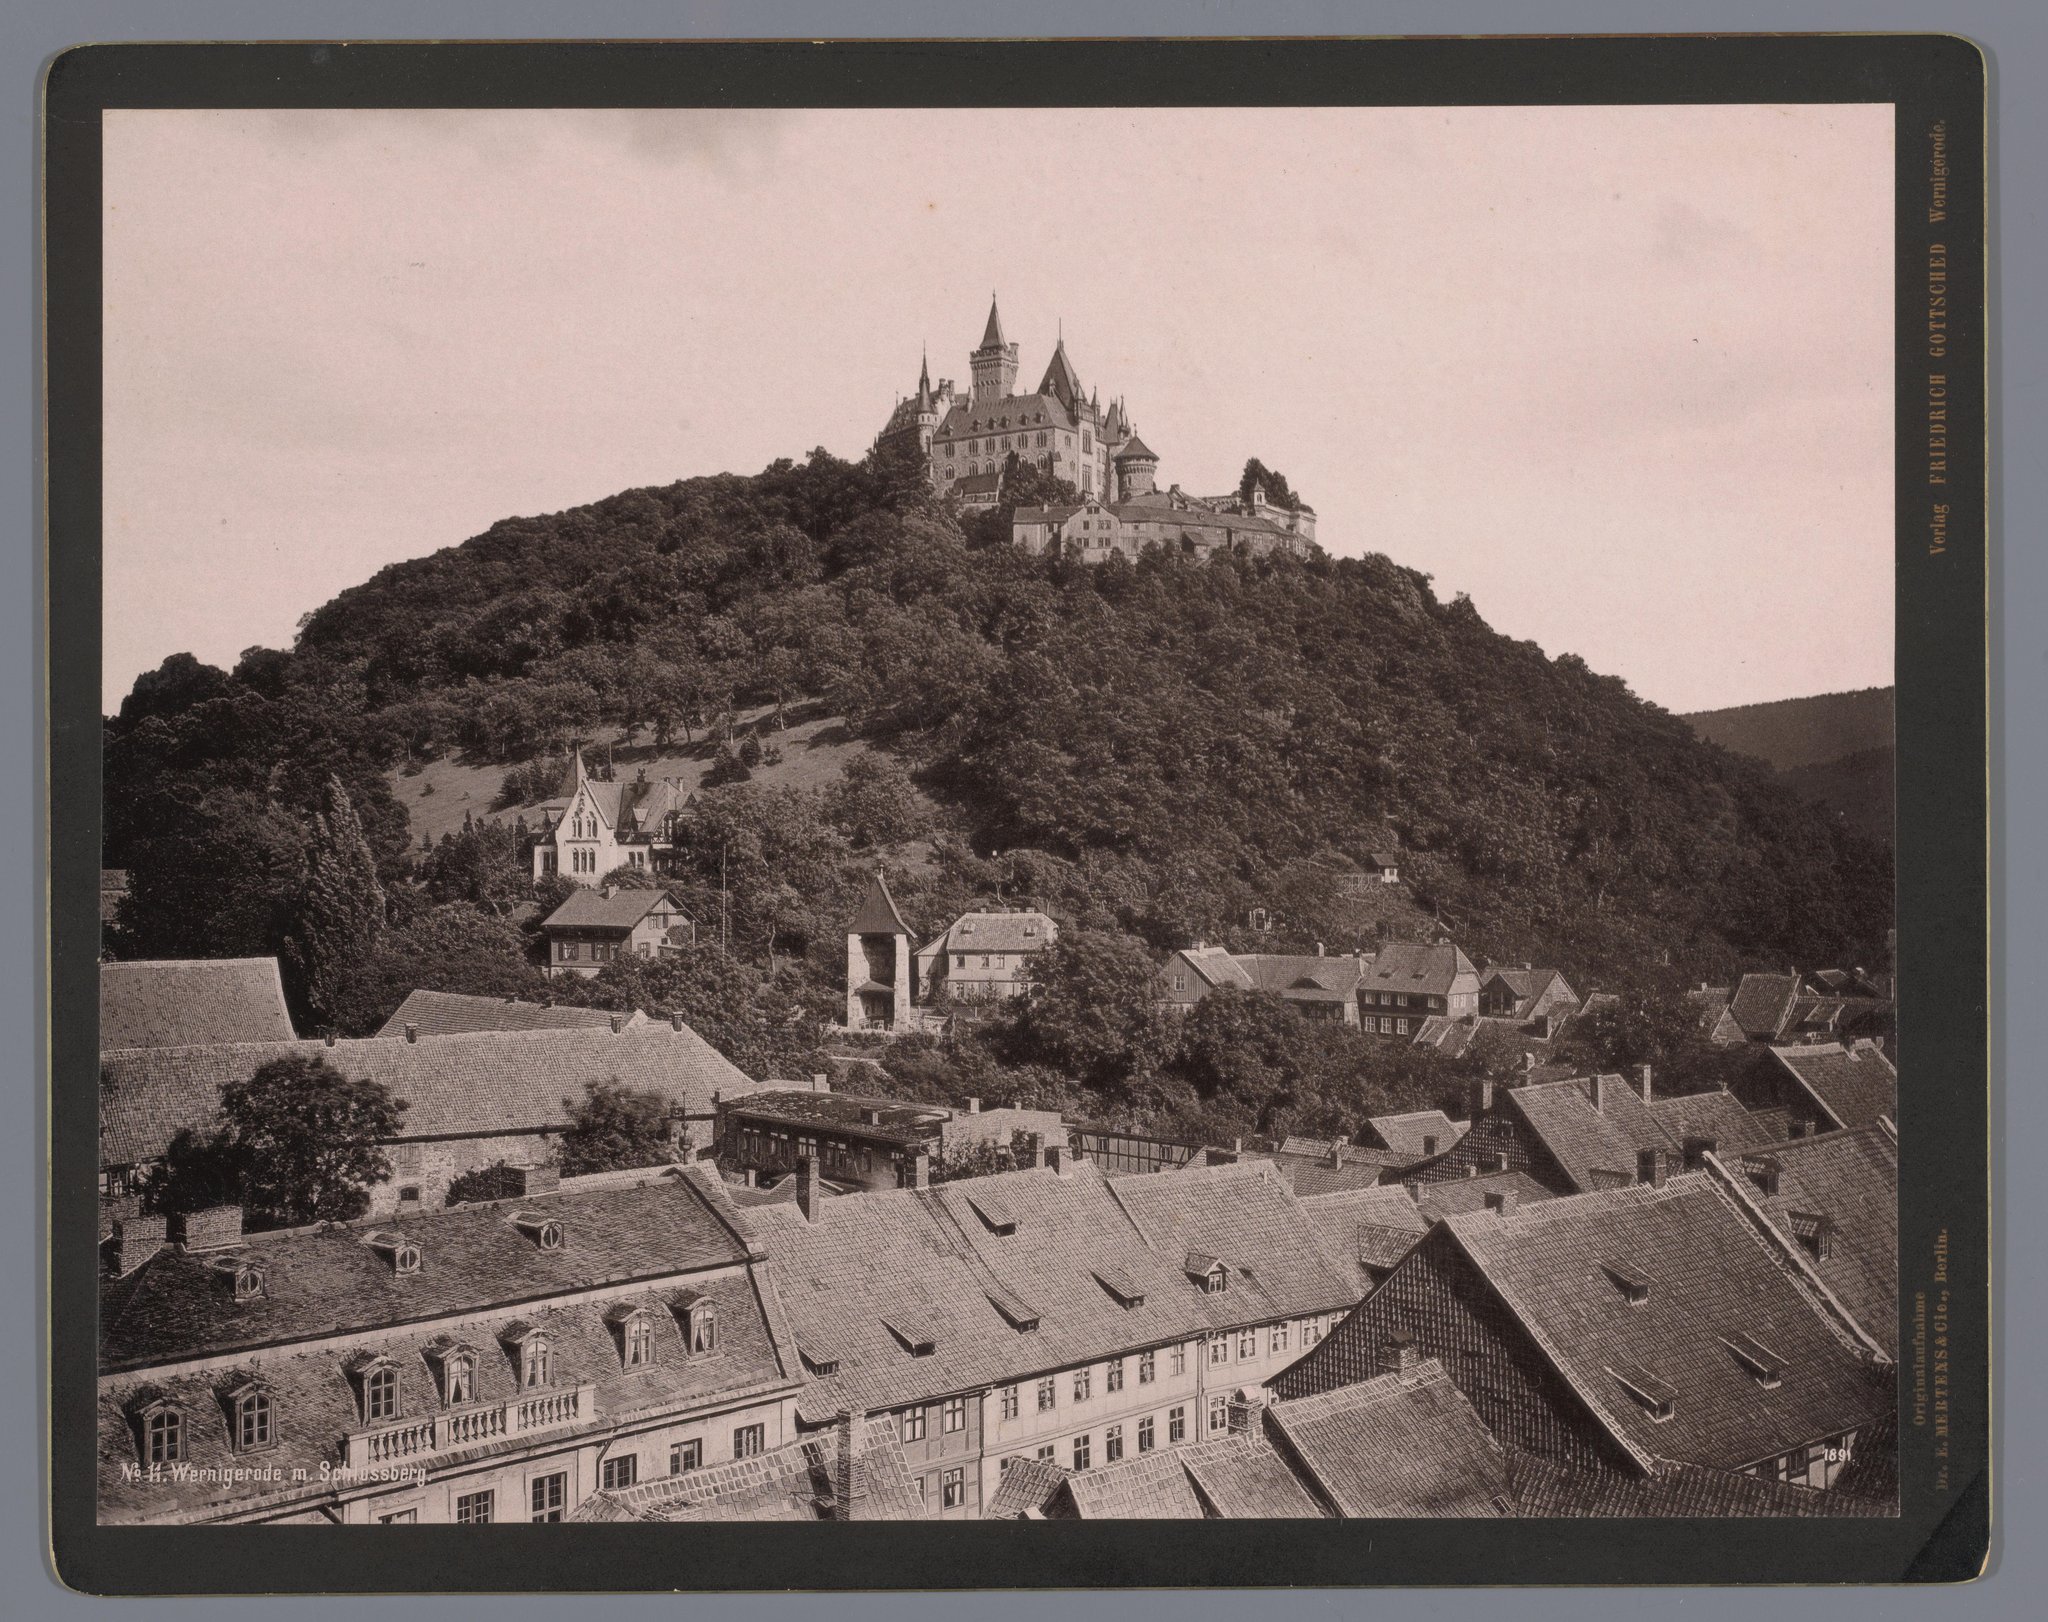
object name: photomechanical print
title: Gezicht op Wernigerode en slot Wernigerode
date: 1891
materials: cardboard, paper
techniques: photograph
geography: wernigerode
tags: city-view in general; 'veduta', castle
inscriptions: inscription: ‘No. 11. Wernigerode m. Schlossberg’